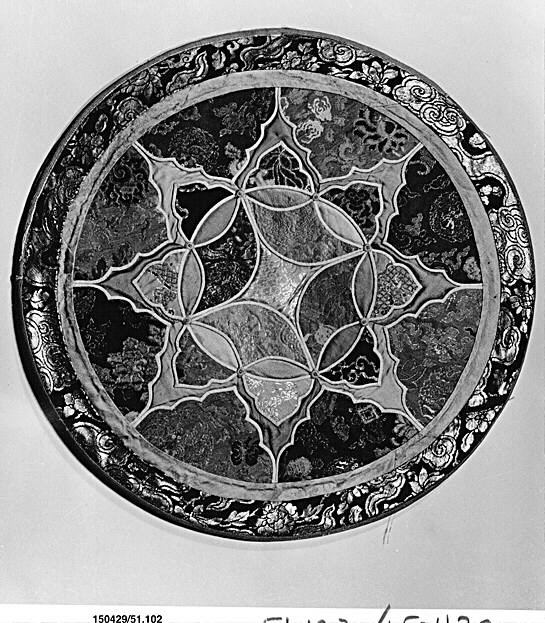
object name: mirror case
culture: chinese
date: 1701-1800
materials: silk